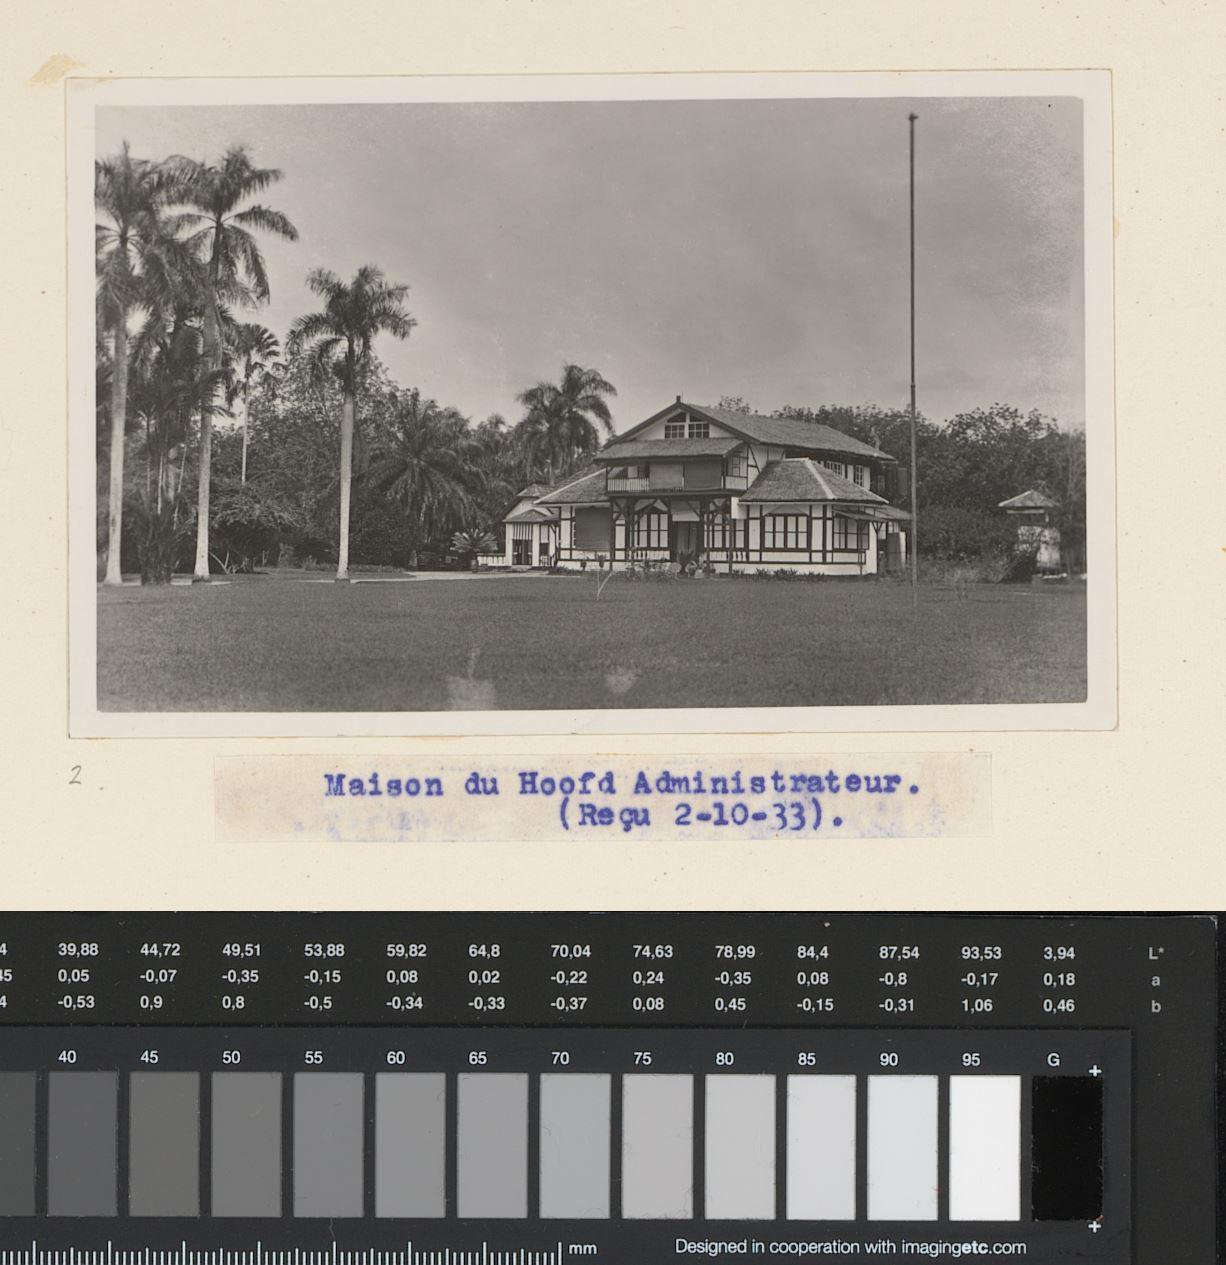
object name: photograph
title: Maison du Hoofd Administrateur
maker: Anonymous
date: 1933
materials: photographic support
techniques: gelatin silver print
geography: sumatra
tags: plantation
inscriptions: inscription: ‘Maison du Hoofd Administrateur (Reçu 2-10-33)’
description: Het huis van de hoofadministrateur van de Sucama bij de plantage Pernantian. Met etiket met onderschrift onder de foto. Onderdeel van het fotoalbum over de plantages Brussel en Pernantian van de Sumatra Caoutchouc Maatschappij op de Oostkust van Sumatra in de jaren 1910-1935.